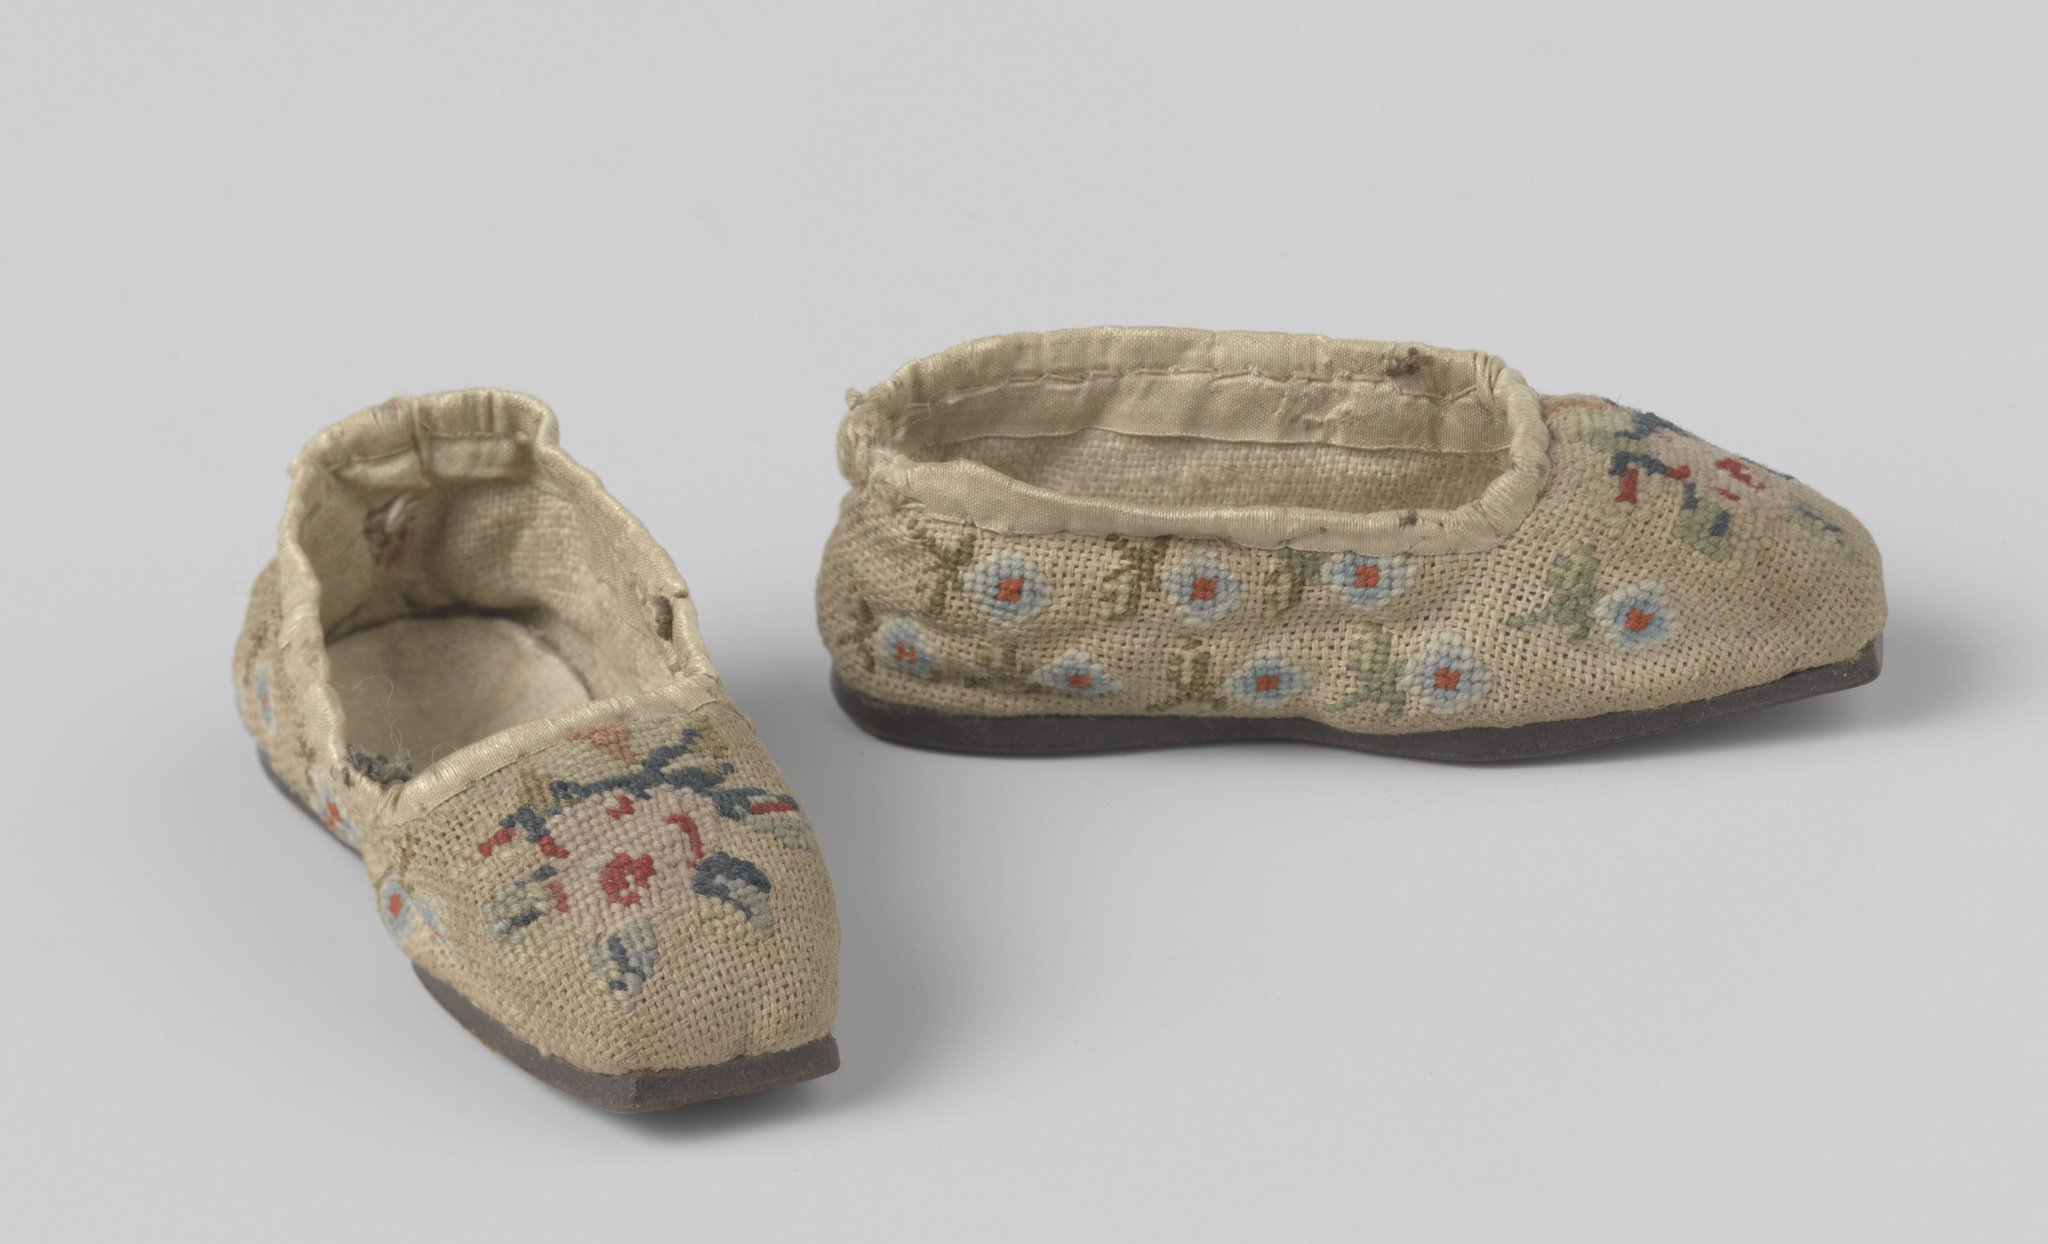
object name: doll's clothing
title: Schoen van linnen geborduurd met bloemen en takken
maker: Anonymous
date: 1825-1850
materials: leather, linen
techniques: embroidered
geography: netherlands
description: Poppenschoen van linnen geborduurd met bloemtakjes in blauw, kruissteek. Op het voorblad een rose roos. Geen hak, vierkante neus.